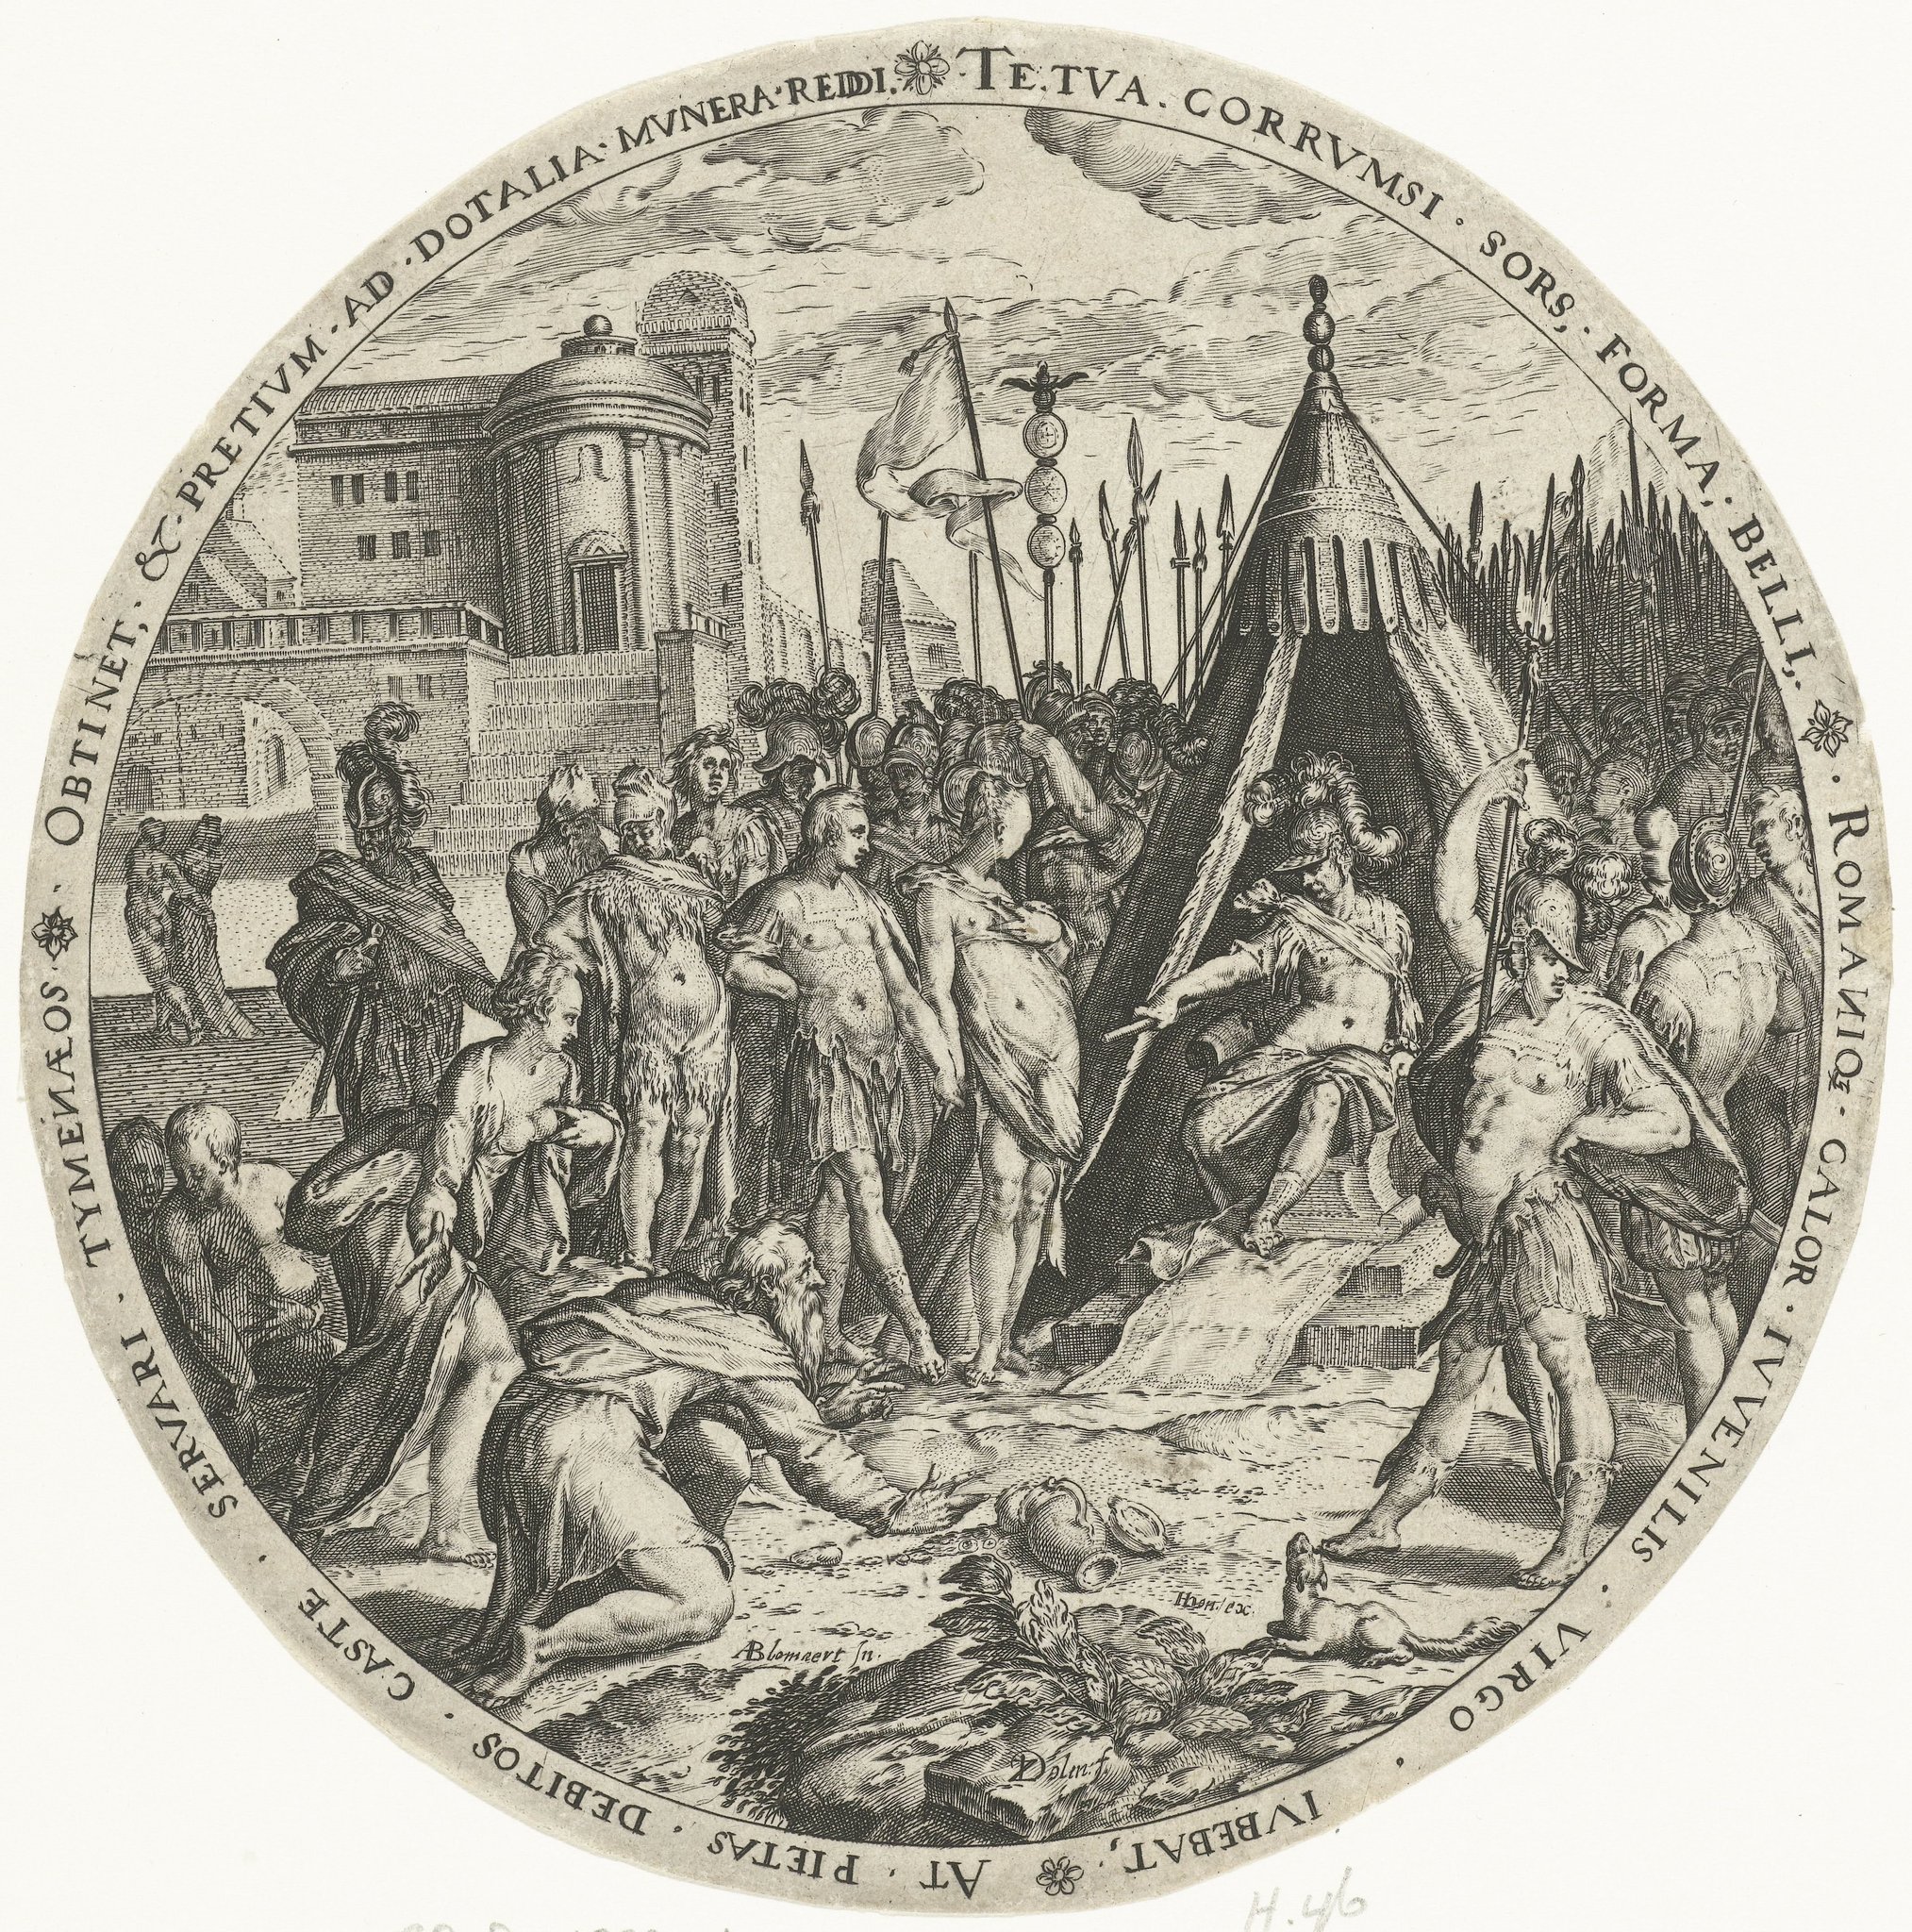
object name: print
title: De edelmoedigheid van Scipio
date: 1593-1600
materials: paper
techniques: engraving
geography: the hague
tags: the continence of scipio: he restores a captive woman to her bridegroom allucius, who kneels before him; the ransom offered by the bride's parents is given to allucius as a wedding-gift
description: Na de overwinning op Nieuw Carthago krijgt de Romeinse generaal Scipio een Spaanse maagd als geschenk aangeboden. Scipio zit in zijn tent voor de stadsmuren van Carthago. Het leger staat achter de tent. Als Scipio hoort dat de maagd verloofd is, geeft hij haar terug aan haar toekomstige bruidegom. De bruidegom en de maagd knielen in dank voor Scipio. Links naast de tent de ouders van het meisje.